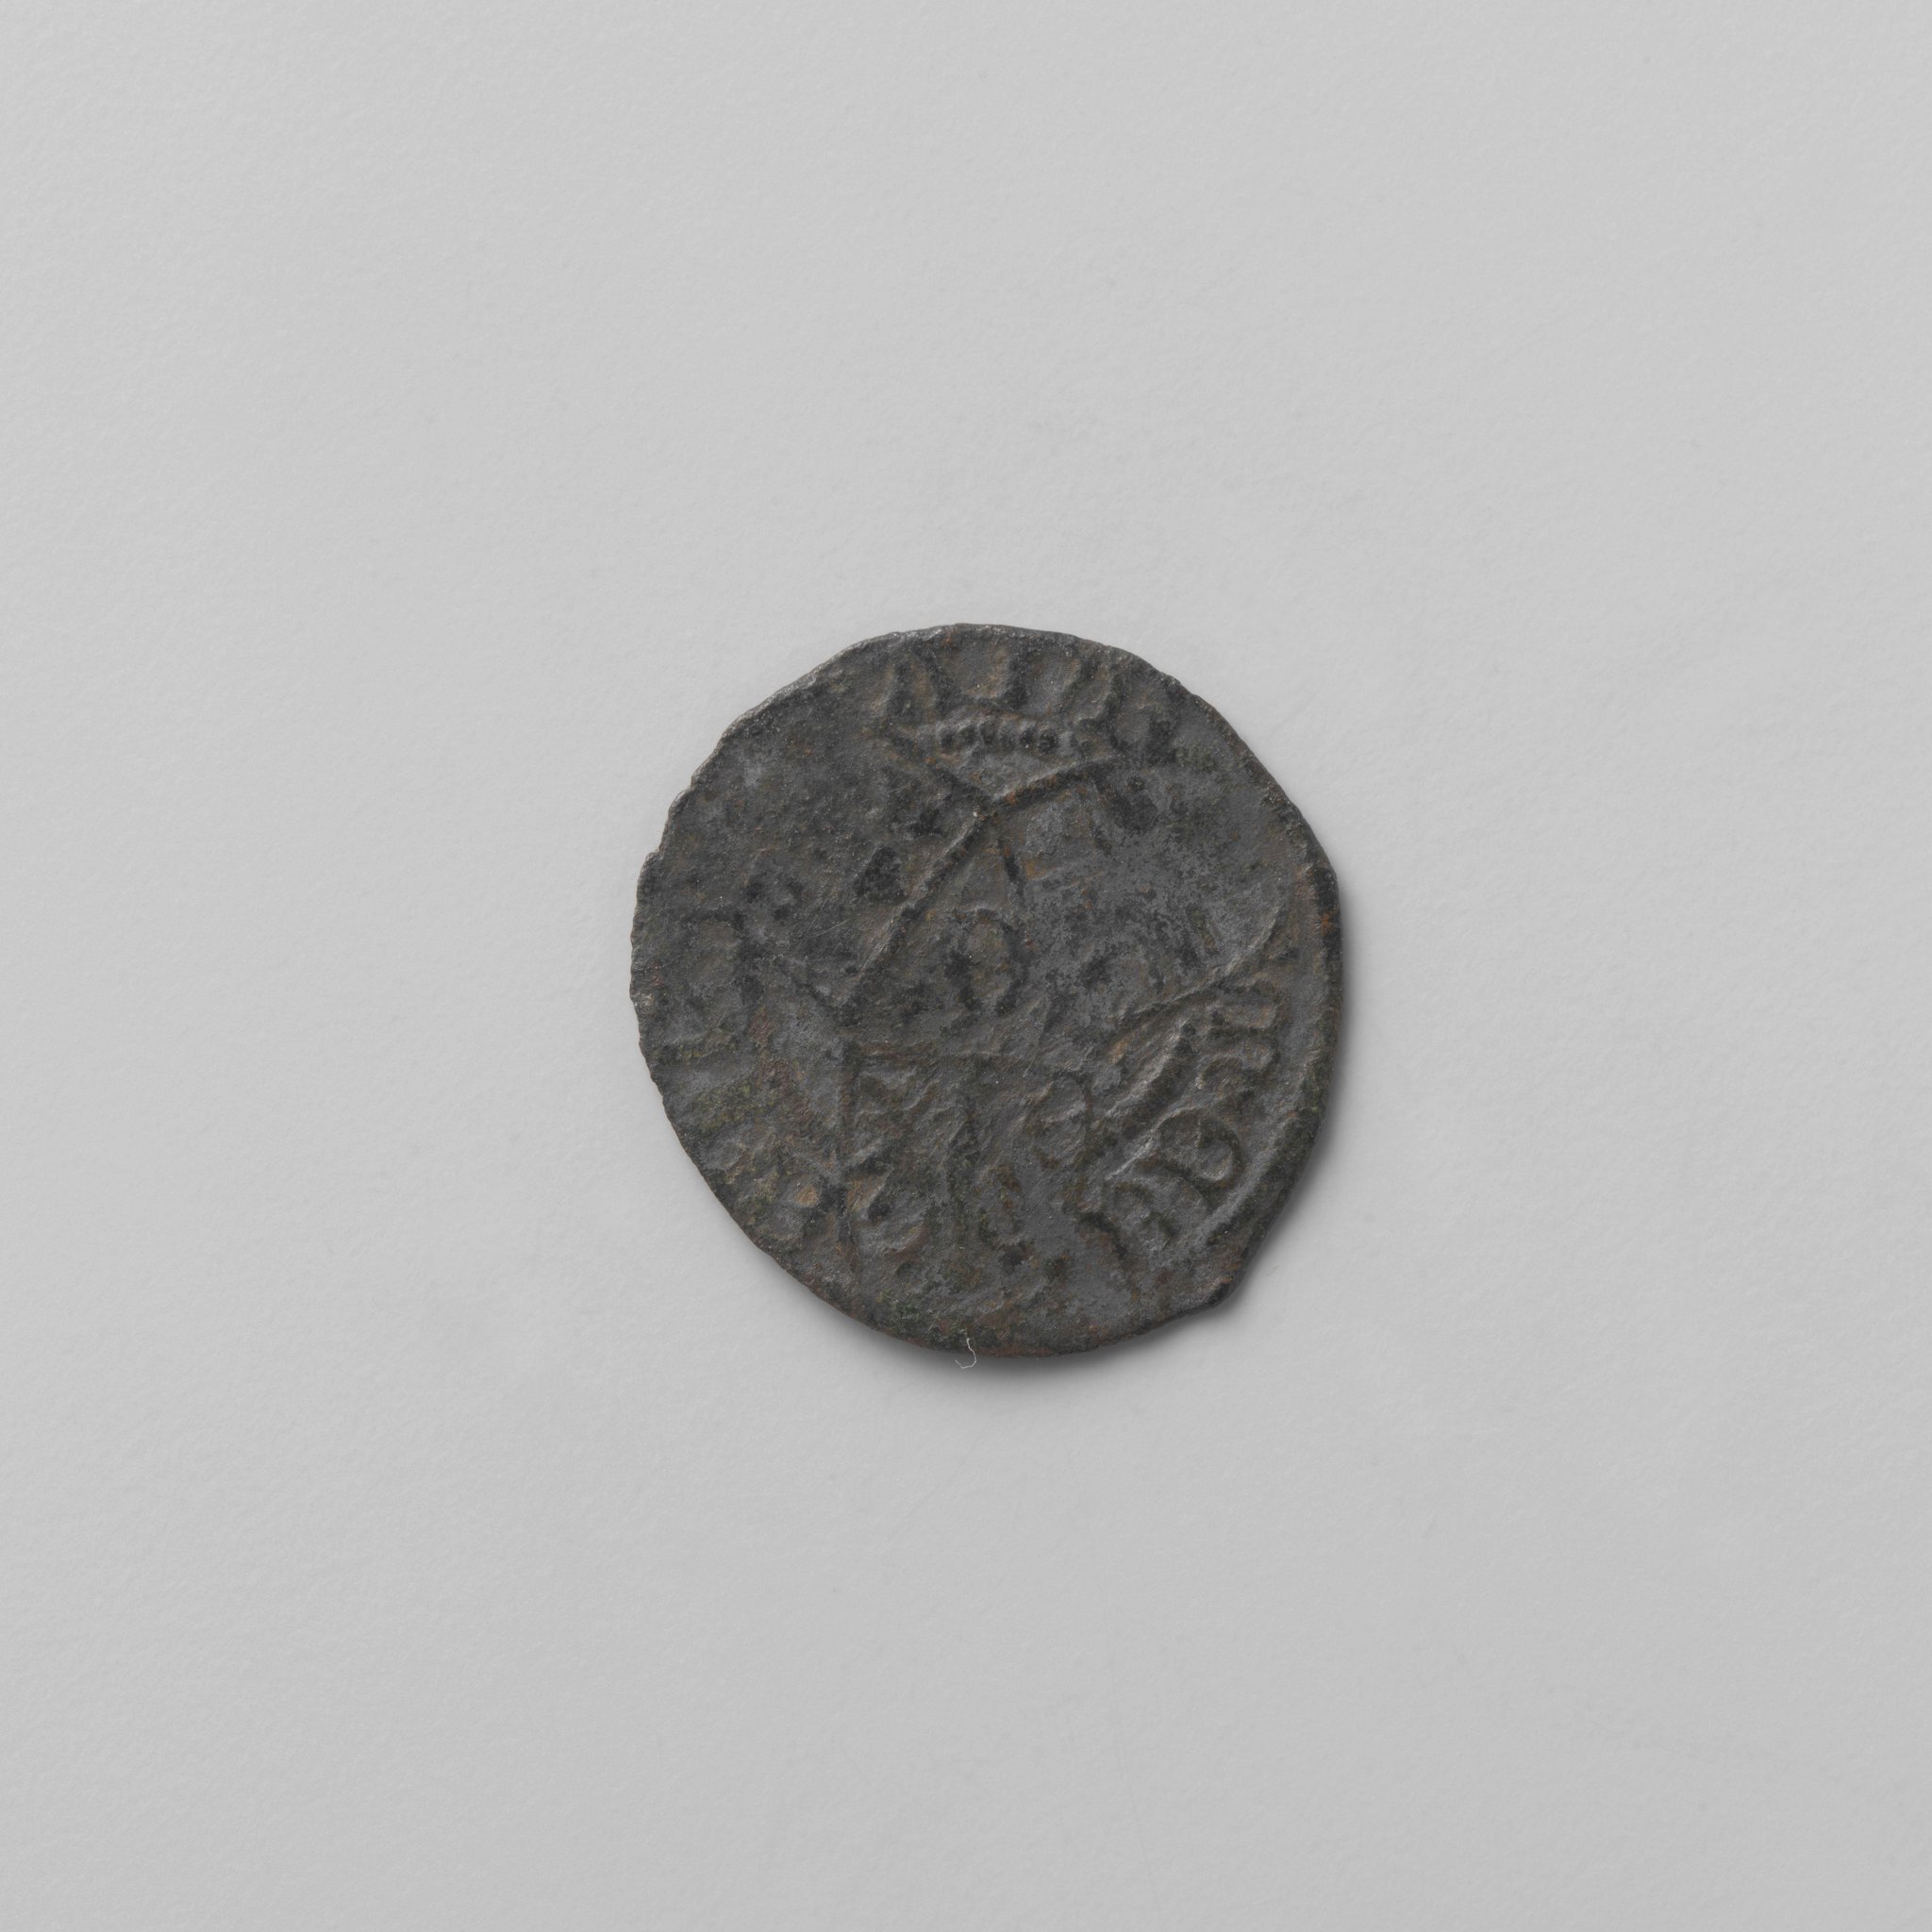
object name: coin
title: Drie Steden, halve plak, 1575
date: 1575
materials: silver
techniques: striking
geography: deventer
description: Koper-zilveren munt. Voorzijde: versierd lang kruis. In het centrum een ster. Keerzijde: wapenschilden van de Drie Steden, in het centrum letter D. Jaartal in omschrift.